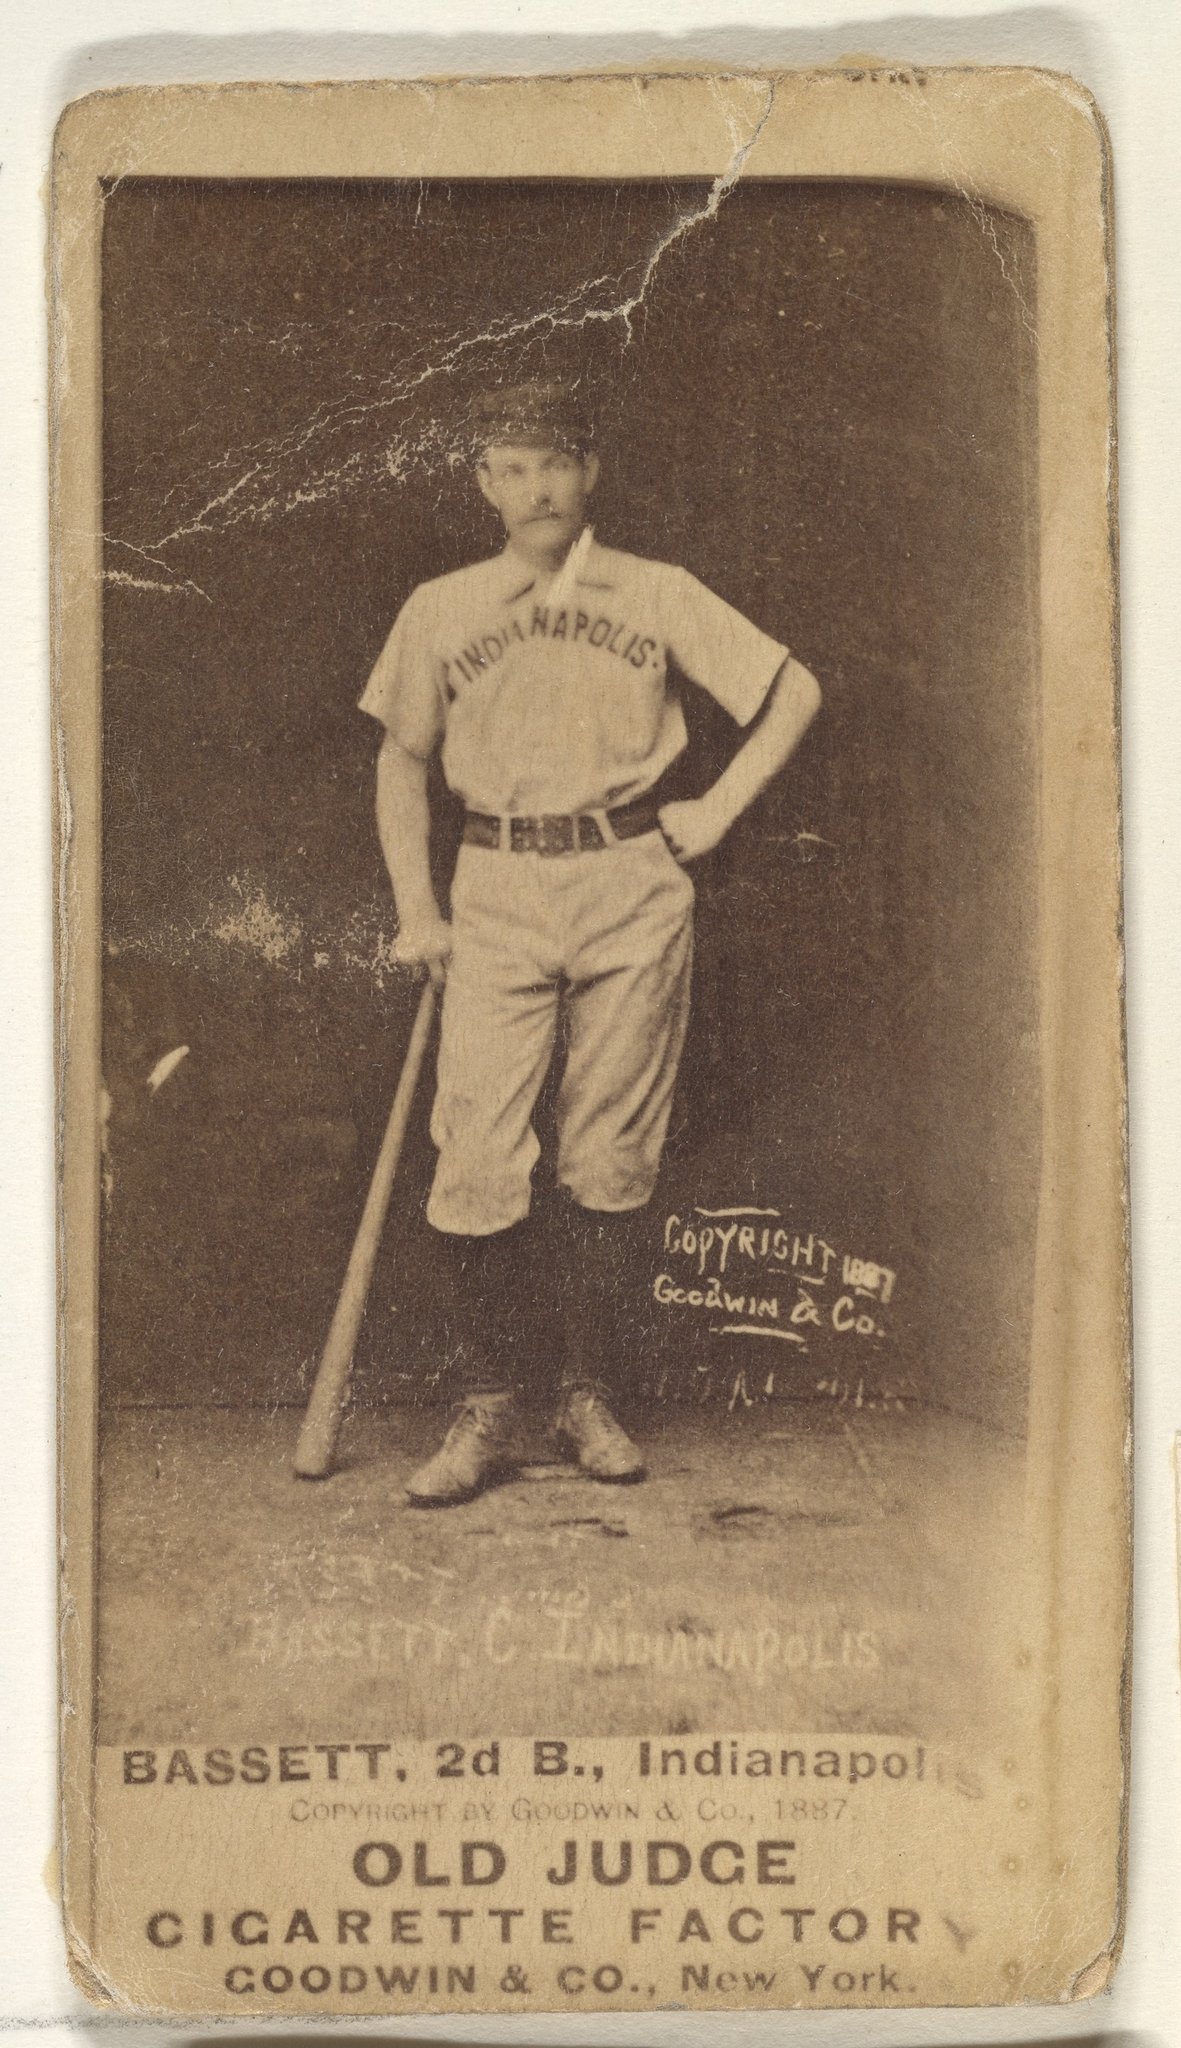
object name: baseball card, photograph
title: Bassett, 2nd Base, Indianapolis, from the Old Judge series (N172) for Old Judge Cigarettes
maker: goodwin & company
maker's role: publisher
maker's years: 1850-1950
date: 1887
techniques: albumen silver print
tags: men,portraits,baseball,athletes